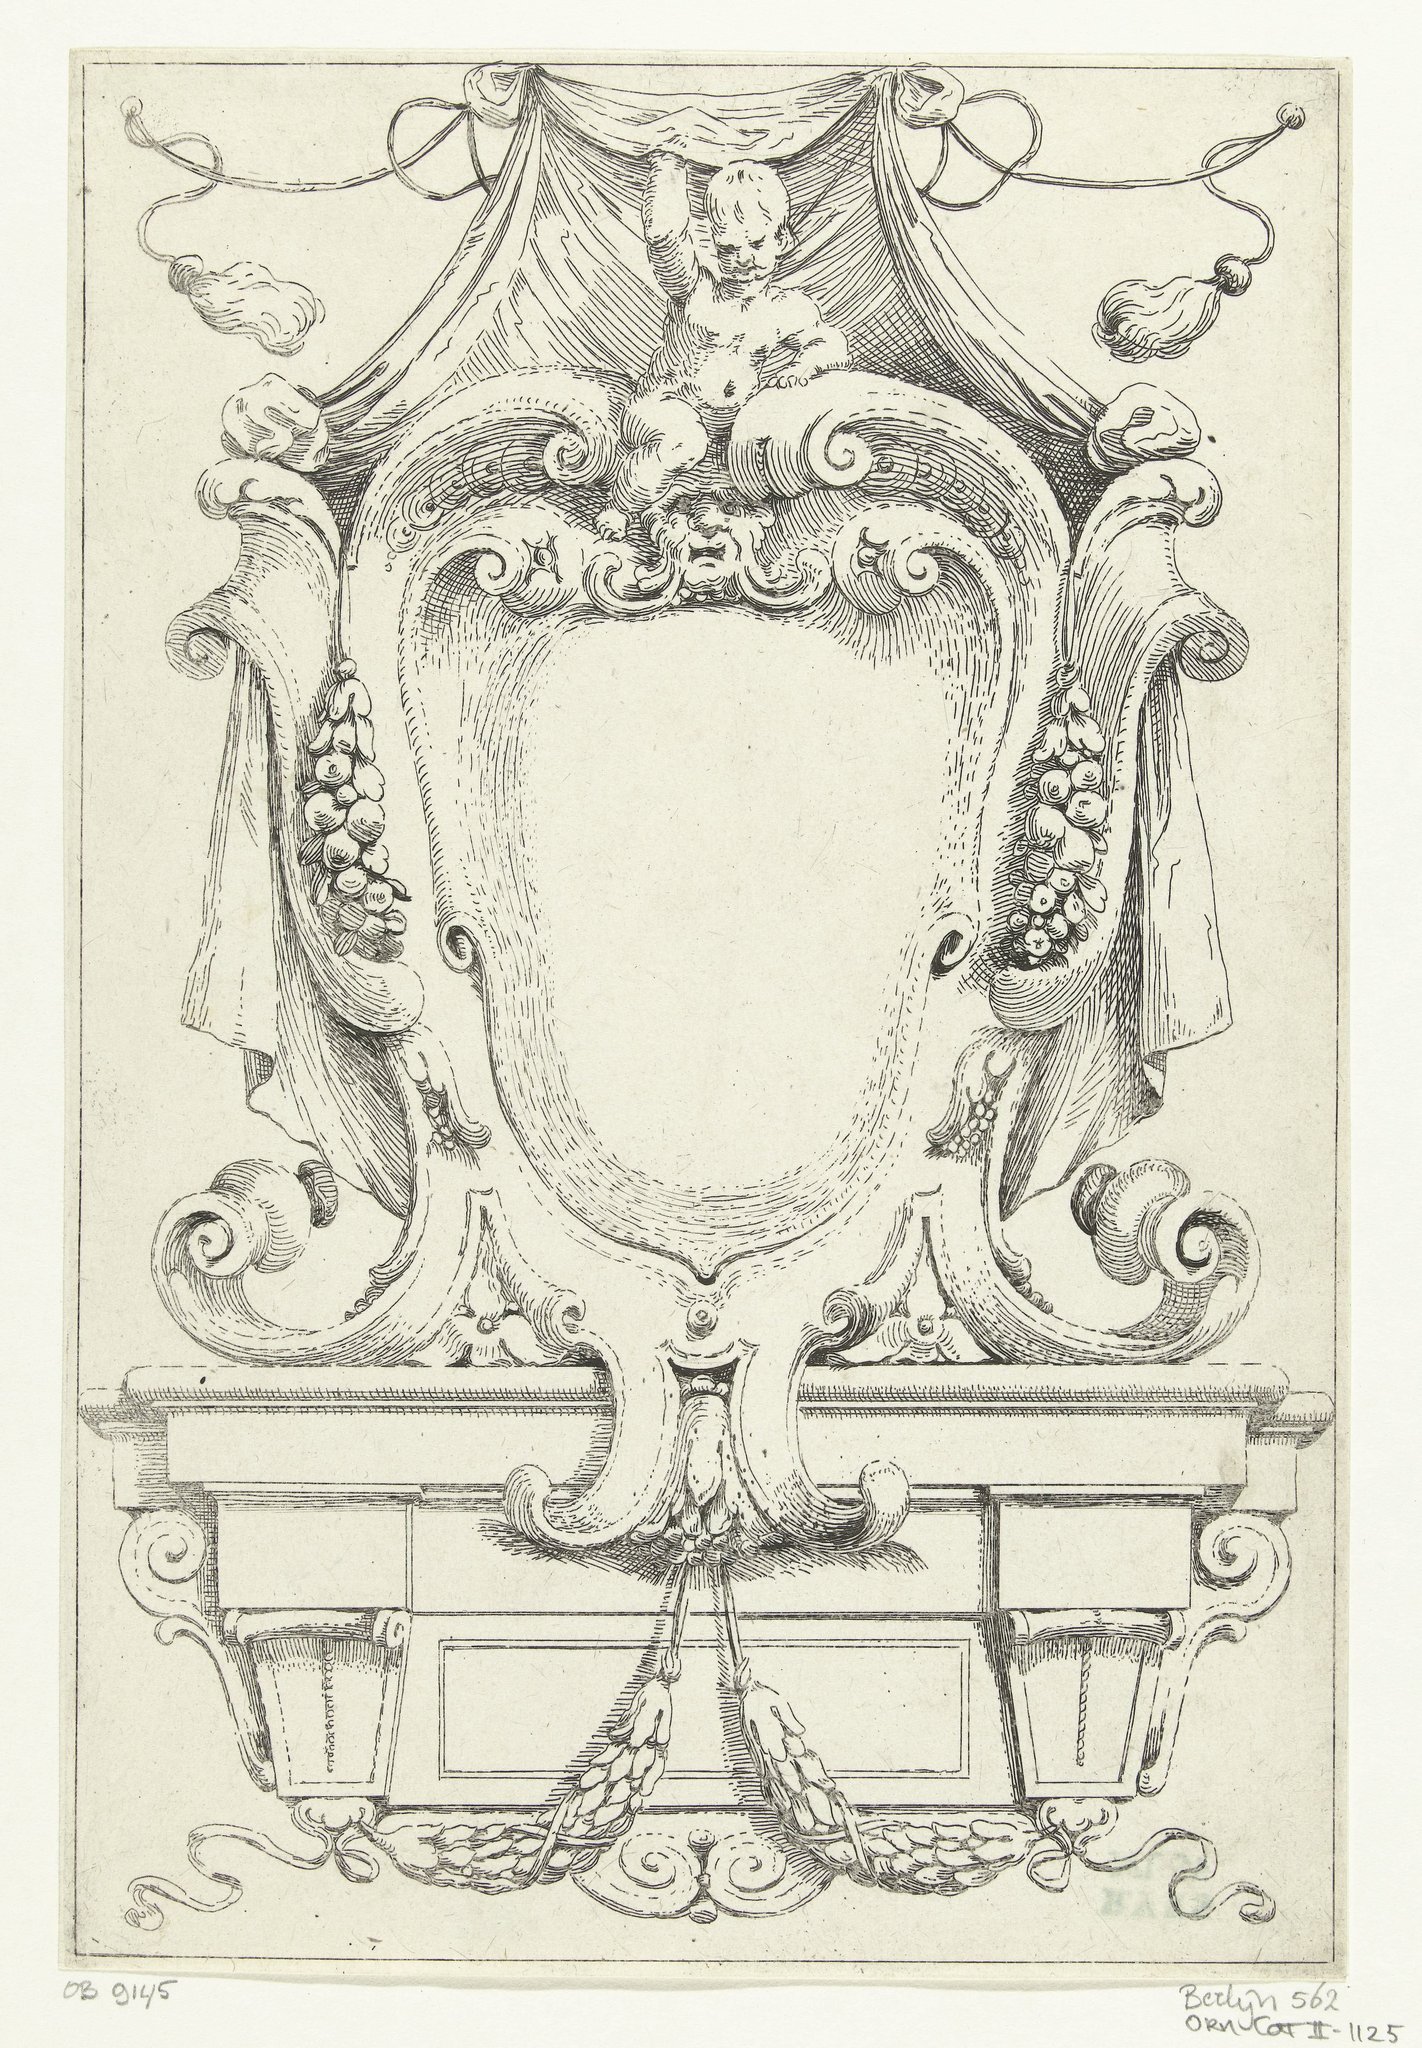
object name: print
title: Cartouche op een muurpostament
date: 1636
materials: paper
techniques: etching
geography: italy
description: Bovenop de cartouche zit een putto die een doek omhoog houdt. Blad uit serie van 24 cartouches en muurdecoraties.